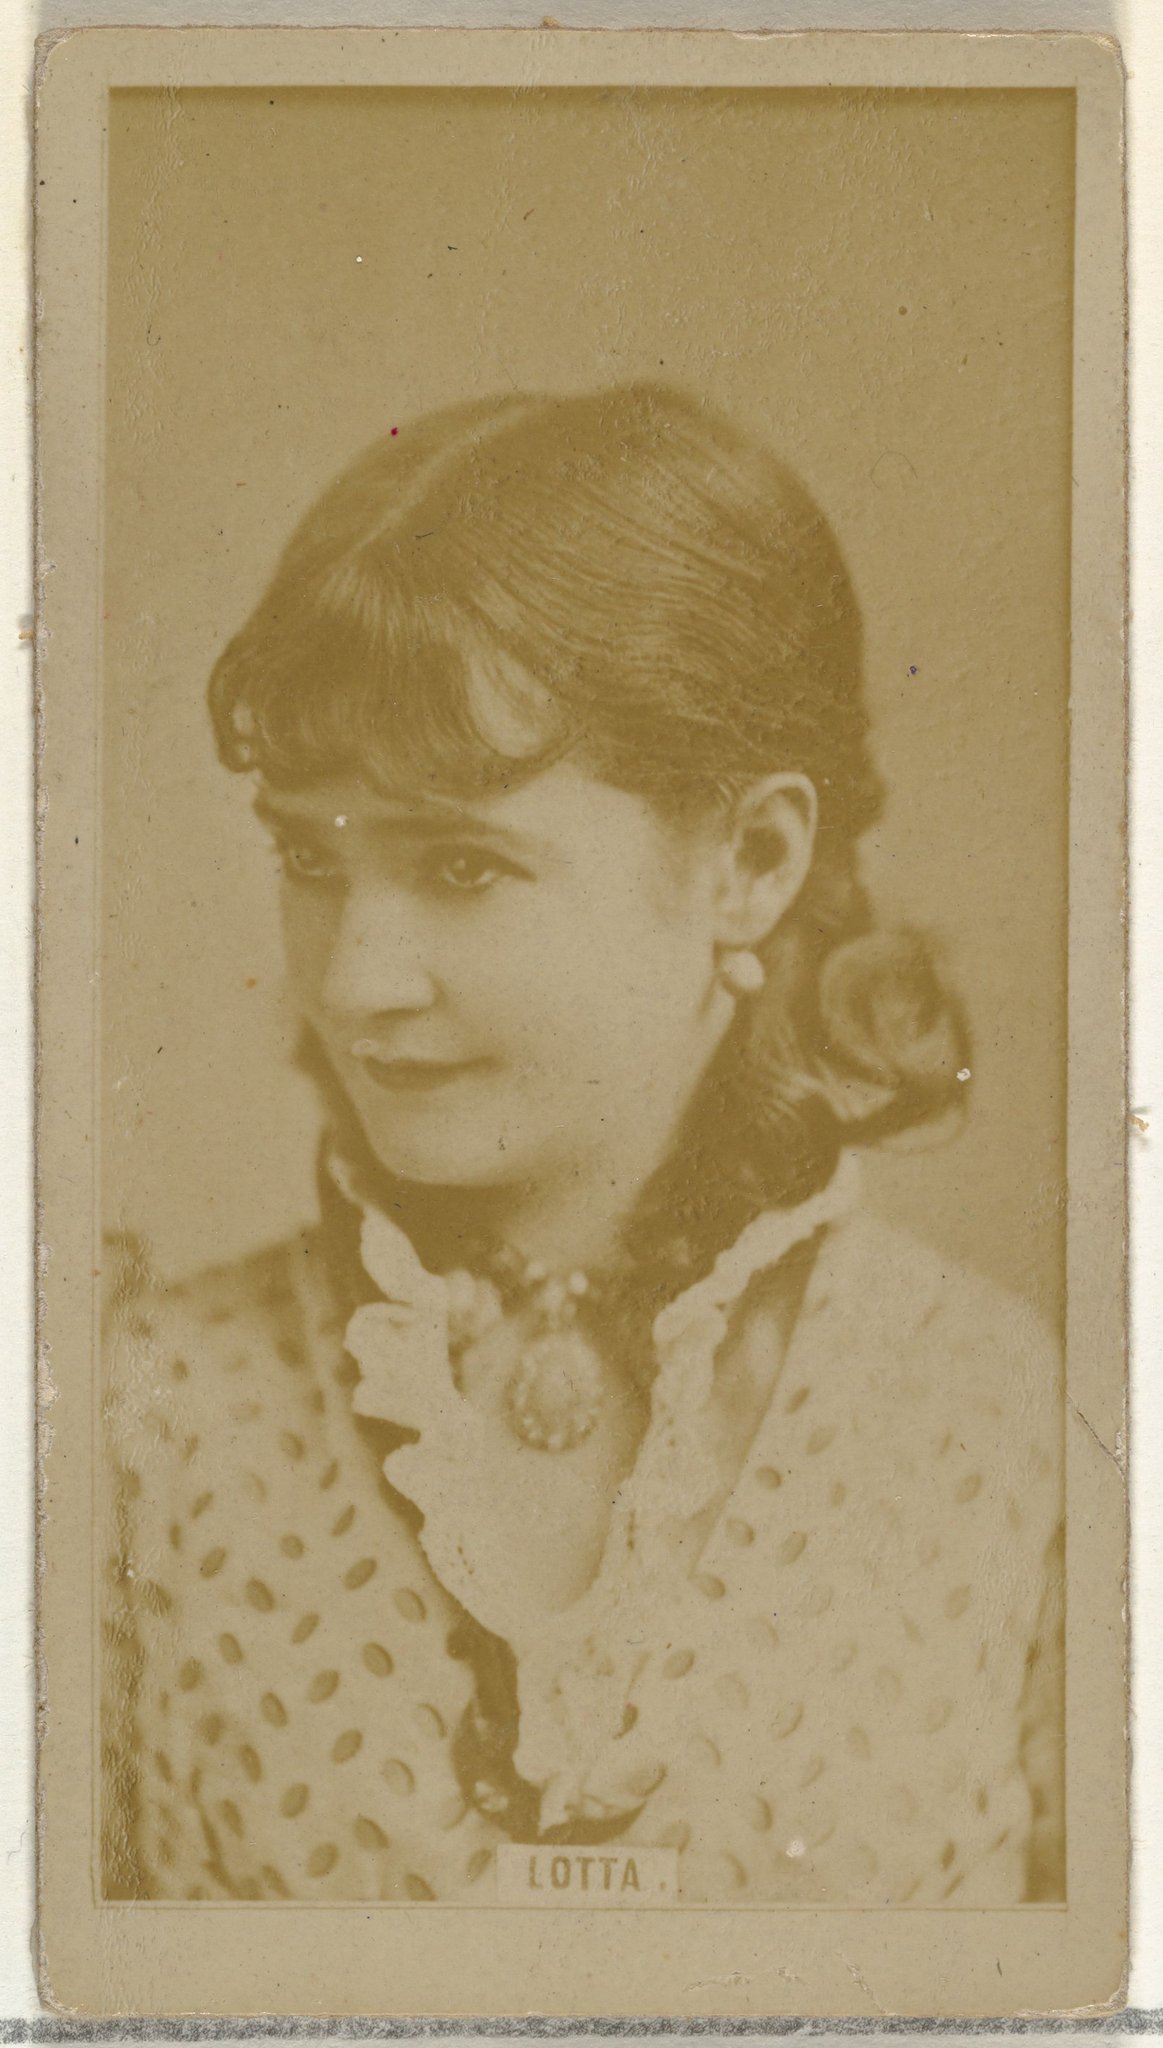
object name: photograph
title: Lotta, from the Actors and Actresses series (N145-8) issued by Duke Sons & Co. to promote Duke Cigarettes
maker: w. duke, sons & co.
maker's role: publisher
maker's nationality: american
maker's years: 1870-1920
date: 1891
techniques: albumen silver print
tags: portraits,women,actresses